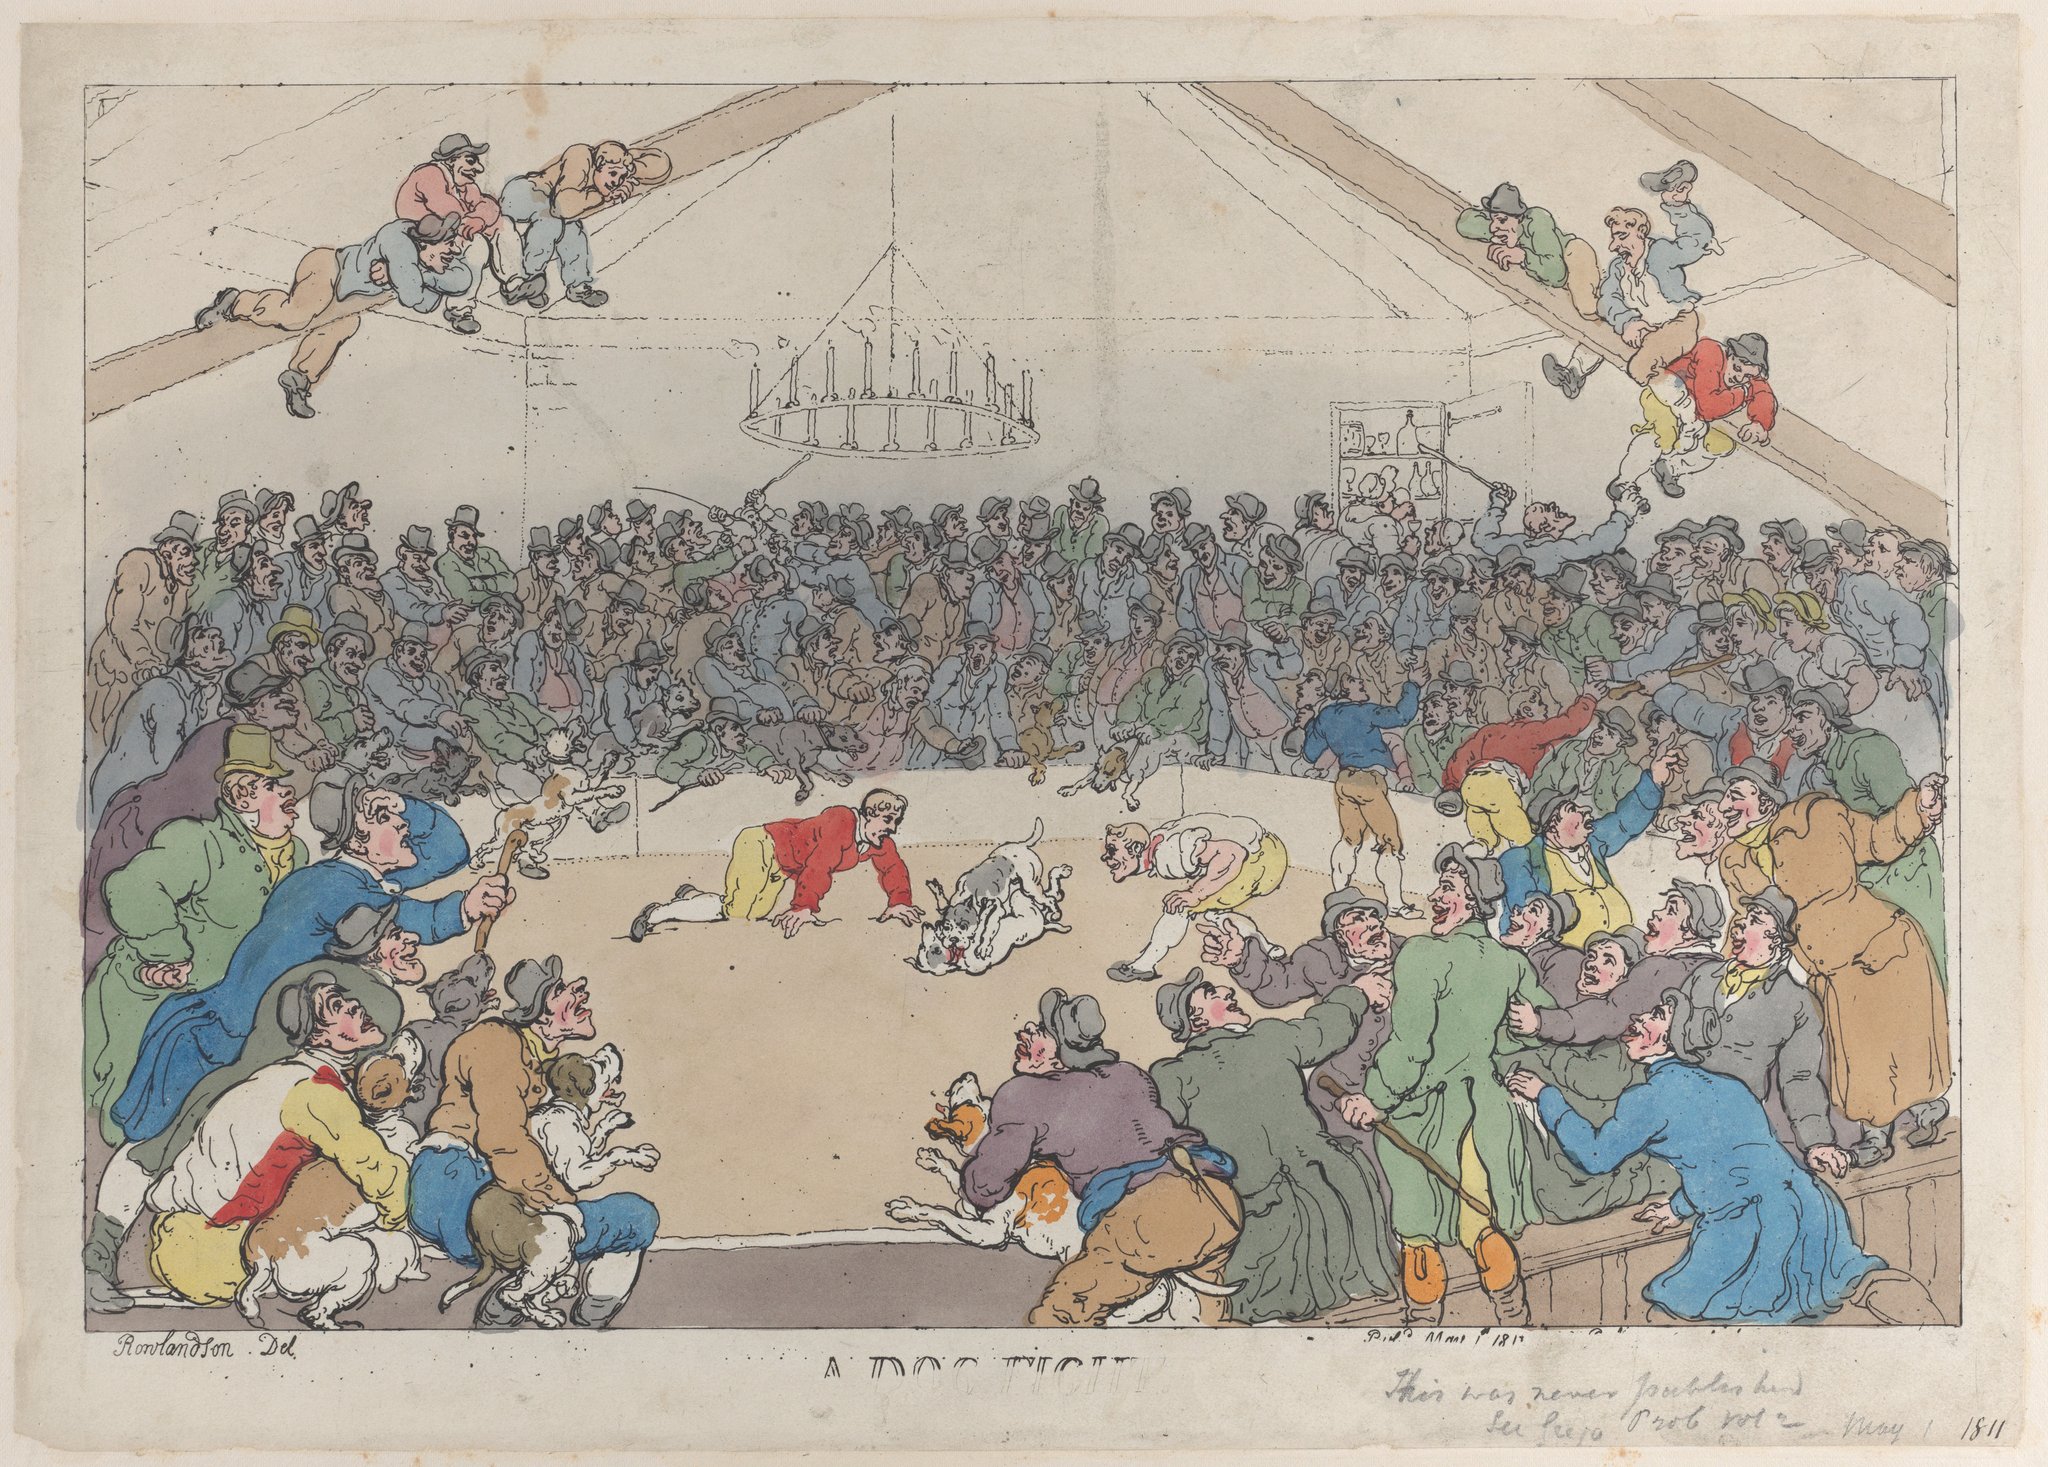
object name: print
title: A Dog Fight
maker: thomas rowlandson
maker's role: artist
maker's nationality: british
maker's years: 1757-1827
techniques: etching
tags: men,spectators,dogs